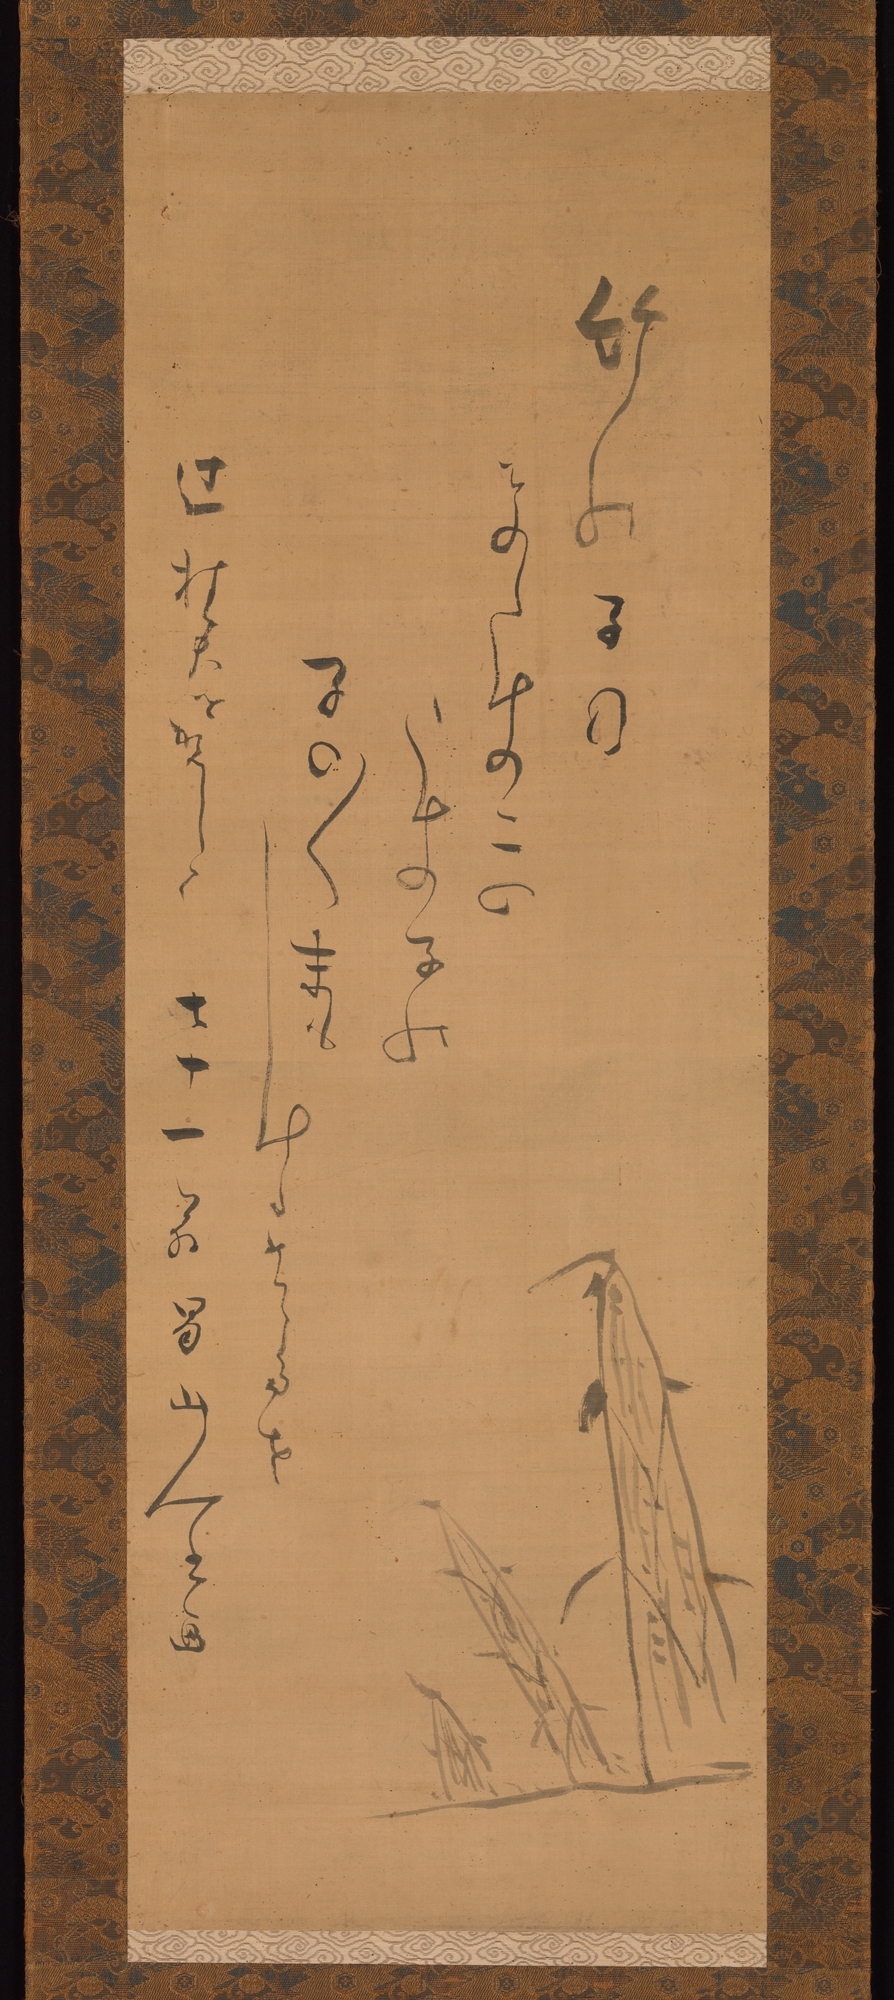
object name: hanging scroll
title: Bamboo Shoots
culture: japanese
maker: shokusanjin (ōta nanpo)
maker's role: artist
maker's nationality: japanese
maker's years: 1749-1823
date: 1820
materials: ink, silk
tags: bamboo